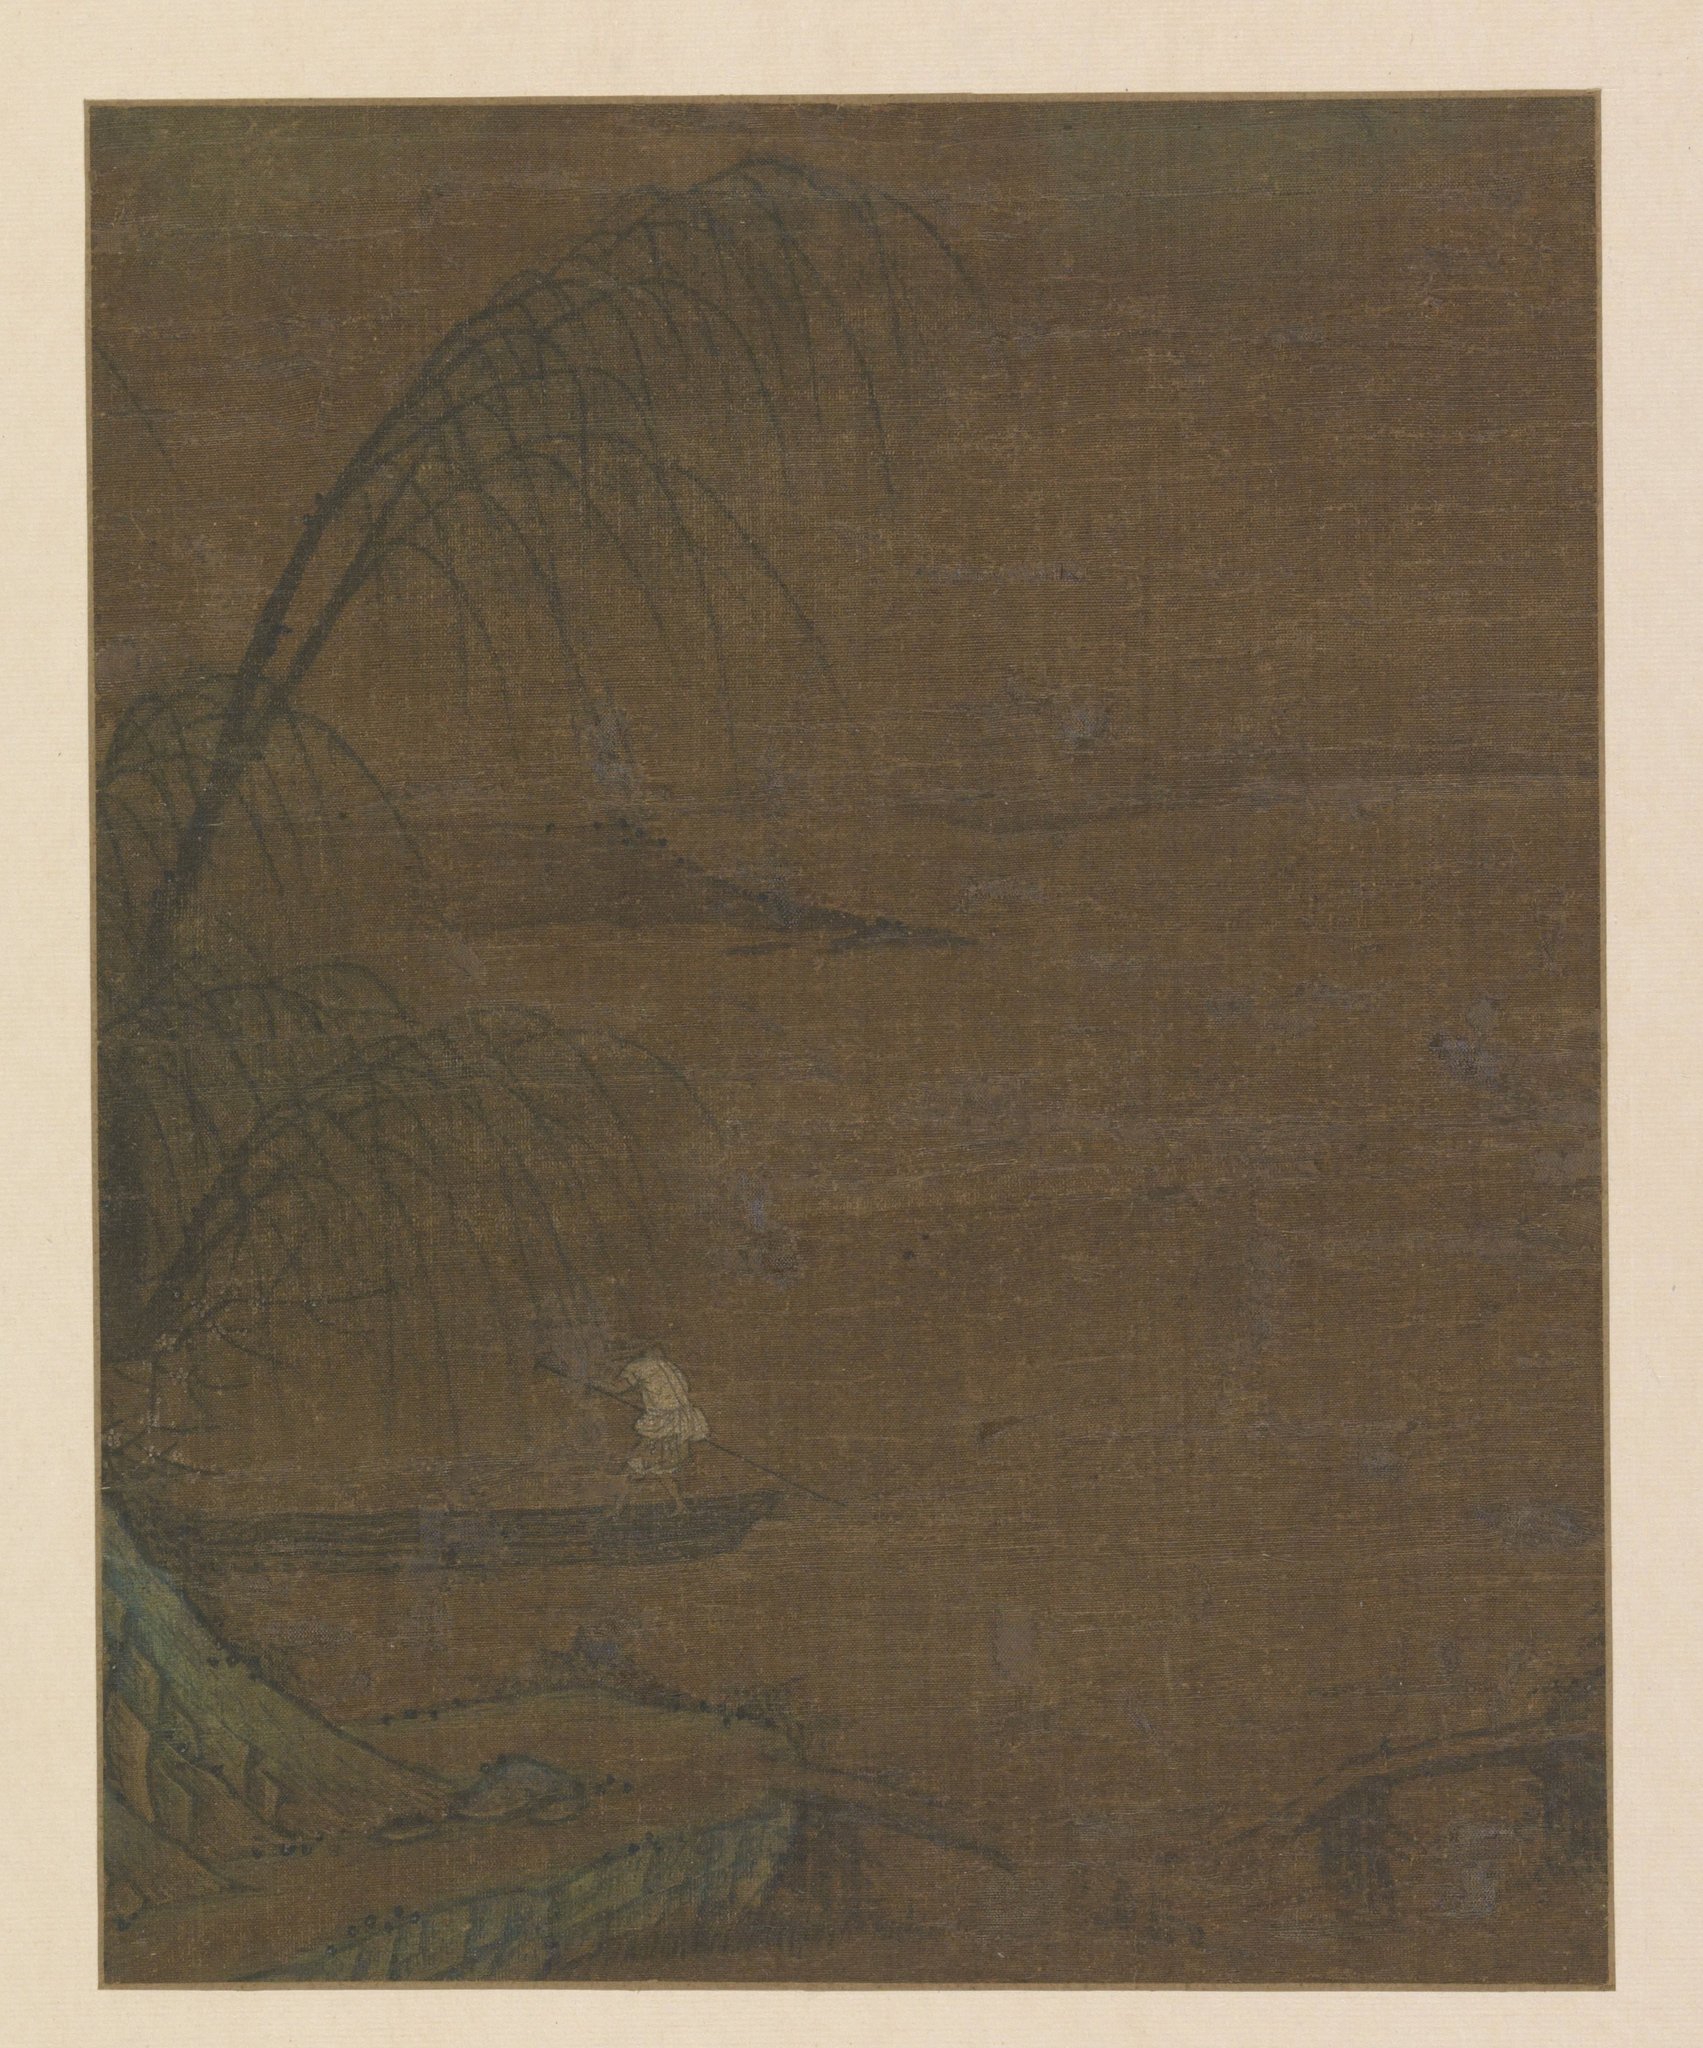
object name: album leaf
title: Waterlandschap met visser in een prauw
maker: Anonymous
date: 1368-1644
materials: ink, silk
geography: china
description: Waterlandschap met een prauw, die door een man wordt geboomd.